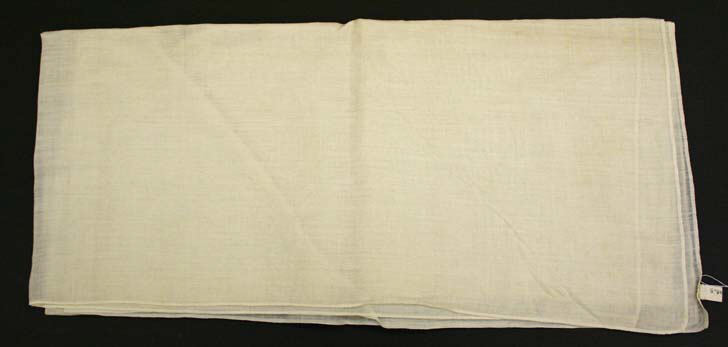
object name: kerchief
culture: european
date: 1701-1800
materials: cotton